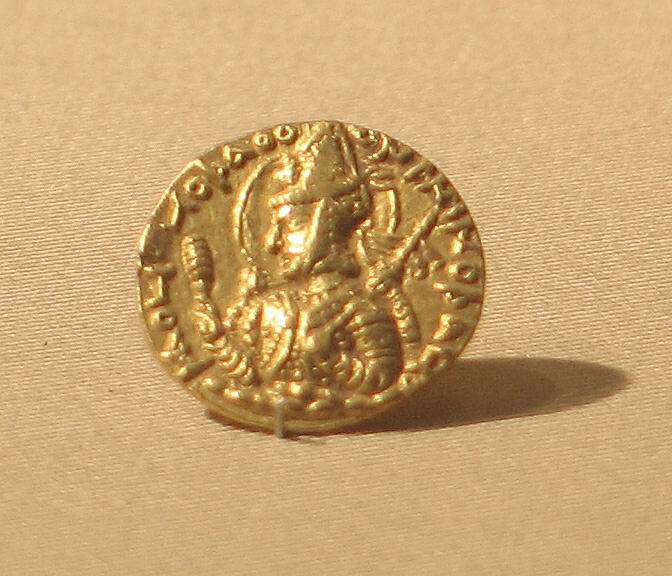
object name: coin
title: Coin of Huvishka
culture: gandhara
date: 150-180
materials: gold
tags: gandhara,men,profiles